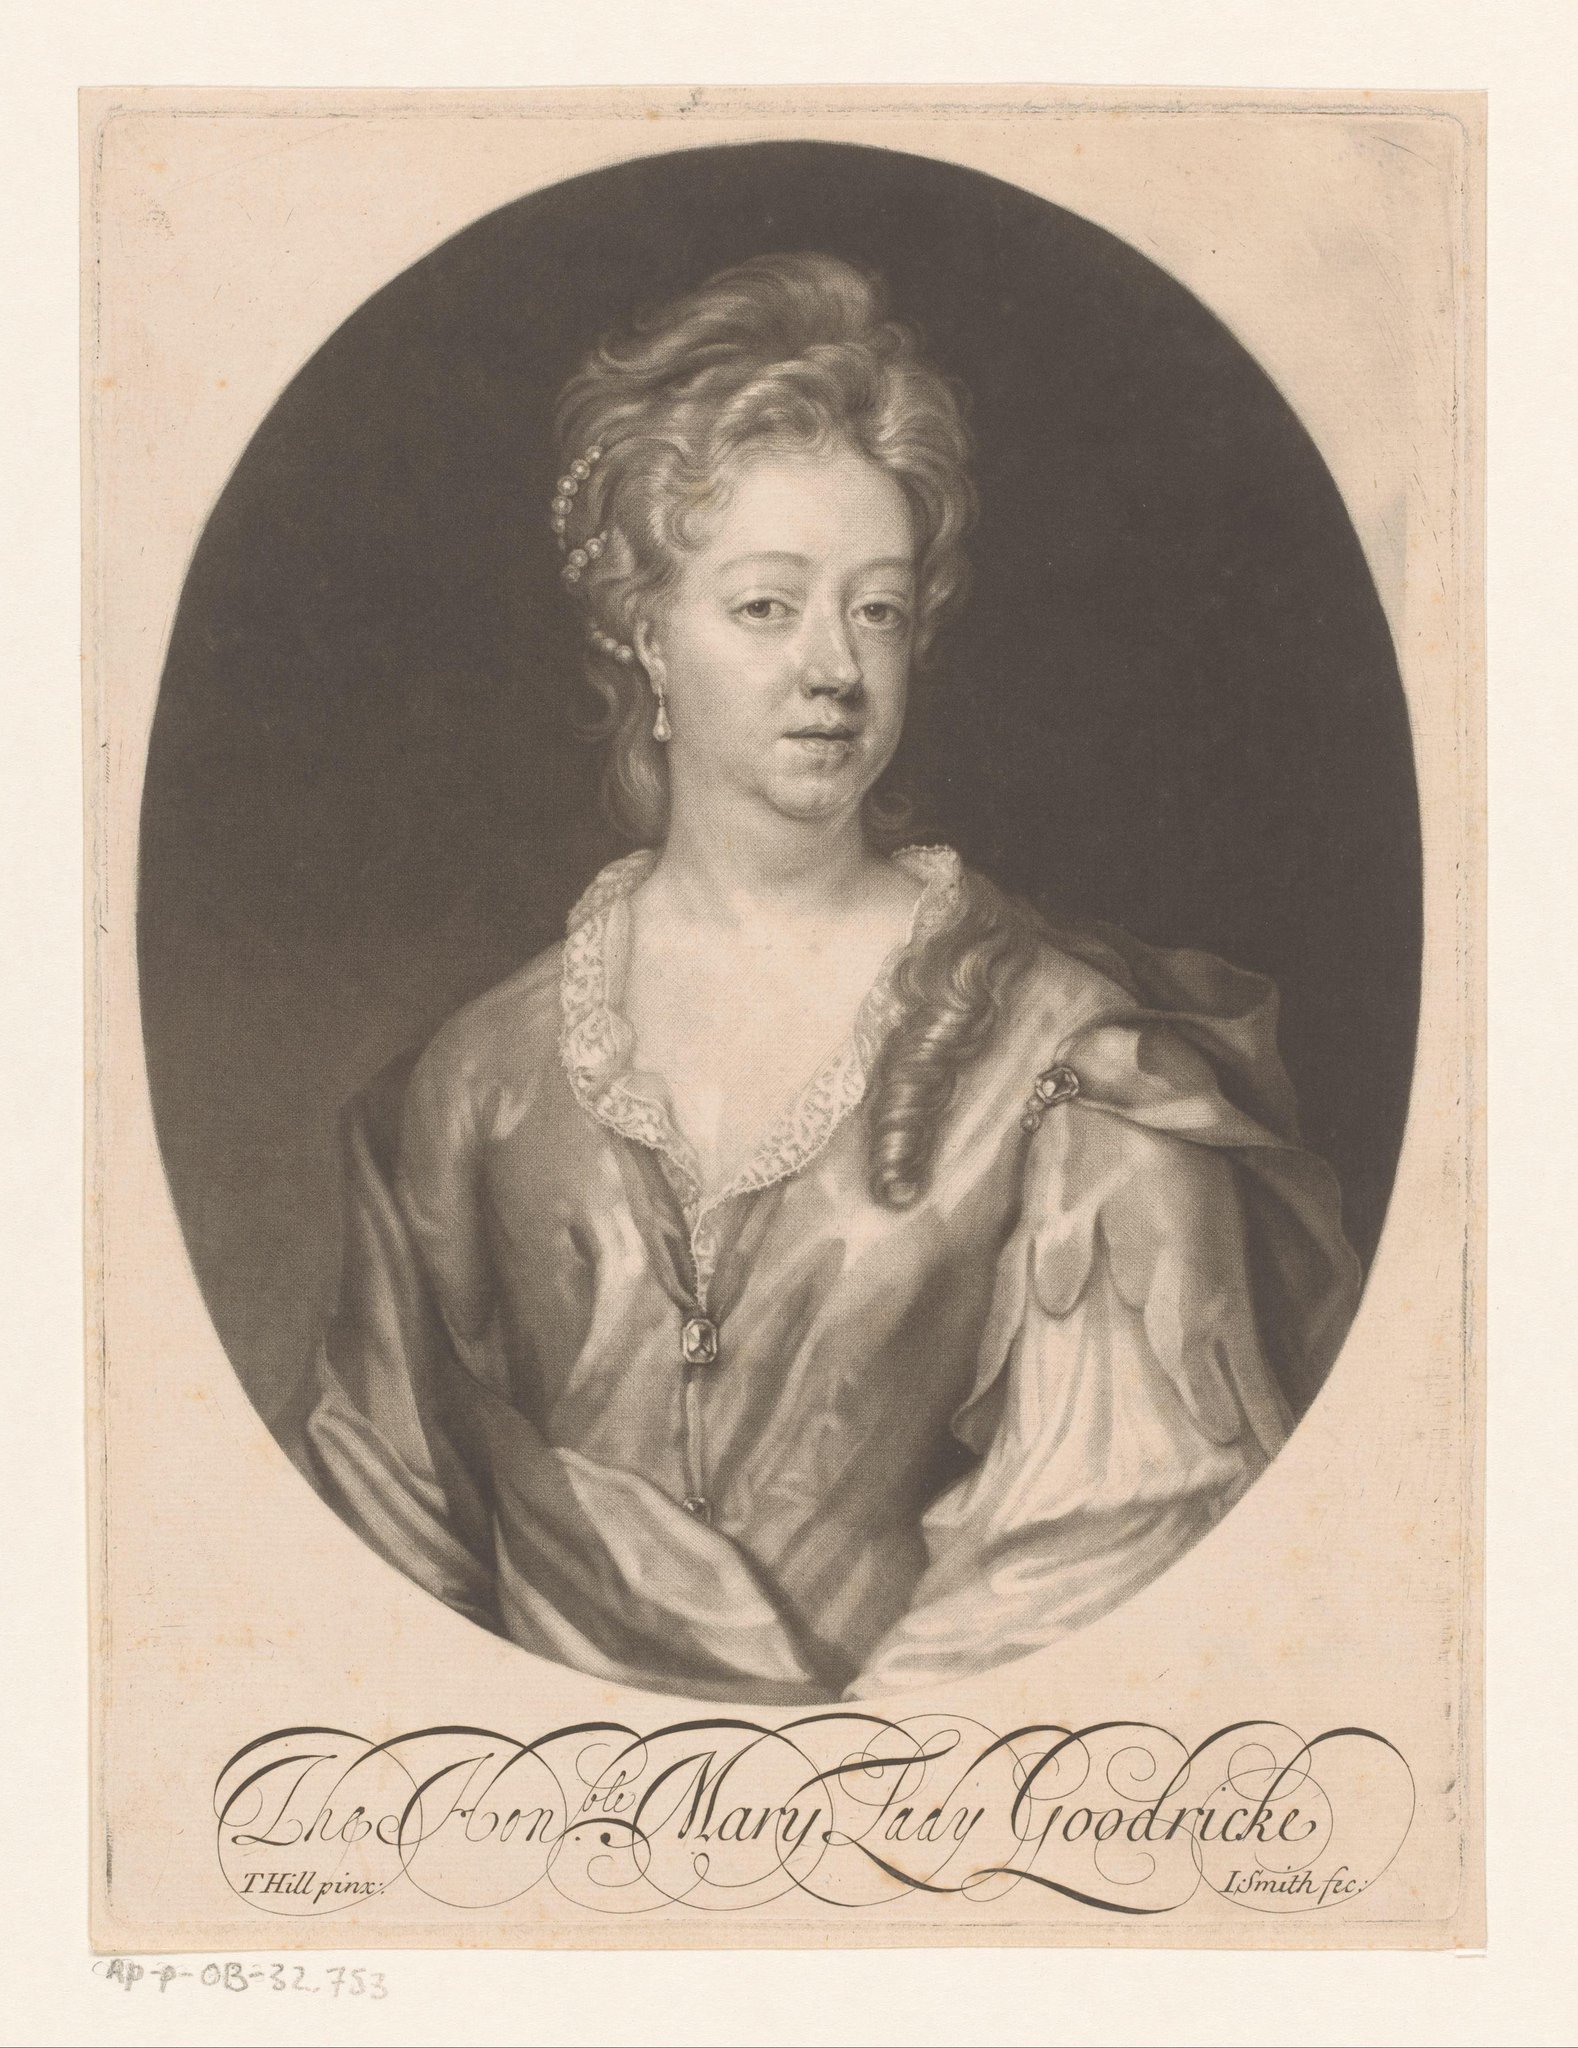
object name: print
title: Portret van Mary Goodricke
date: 1662-1742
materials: paper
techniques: mezzotint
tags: historical persons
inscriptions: collector's mark: Lugt 240